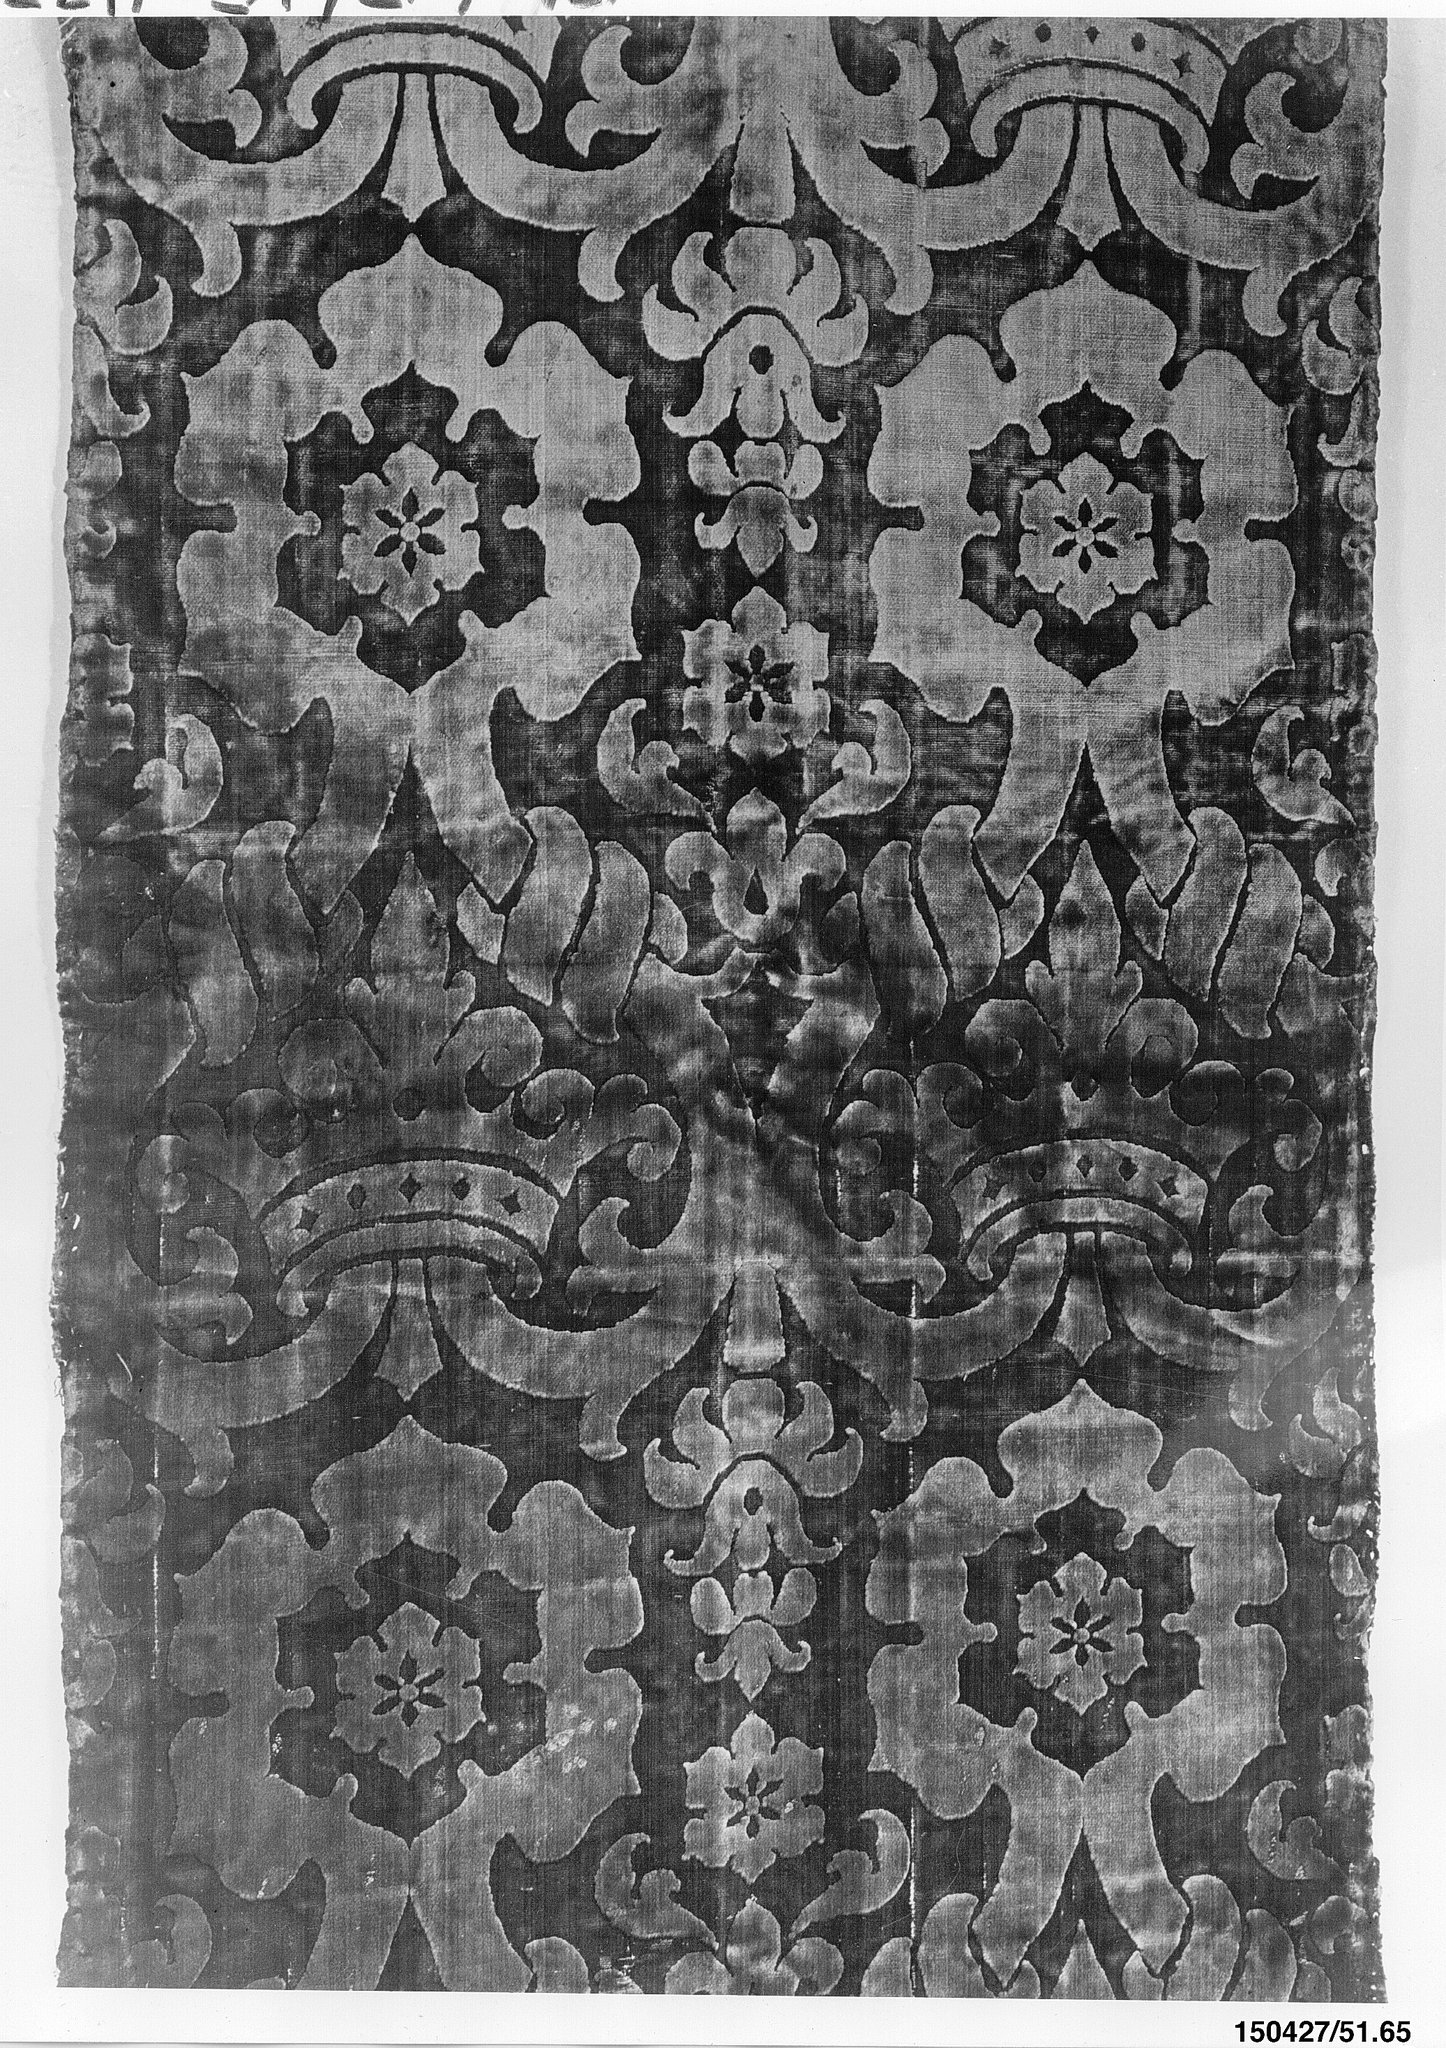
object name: length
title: Length of velvet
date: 1501-1600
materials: silk